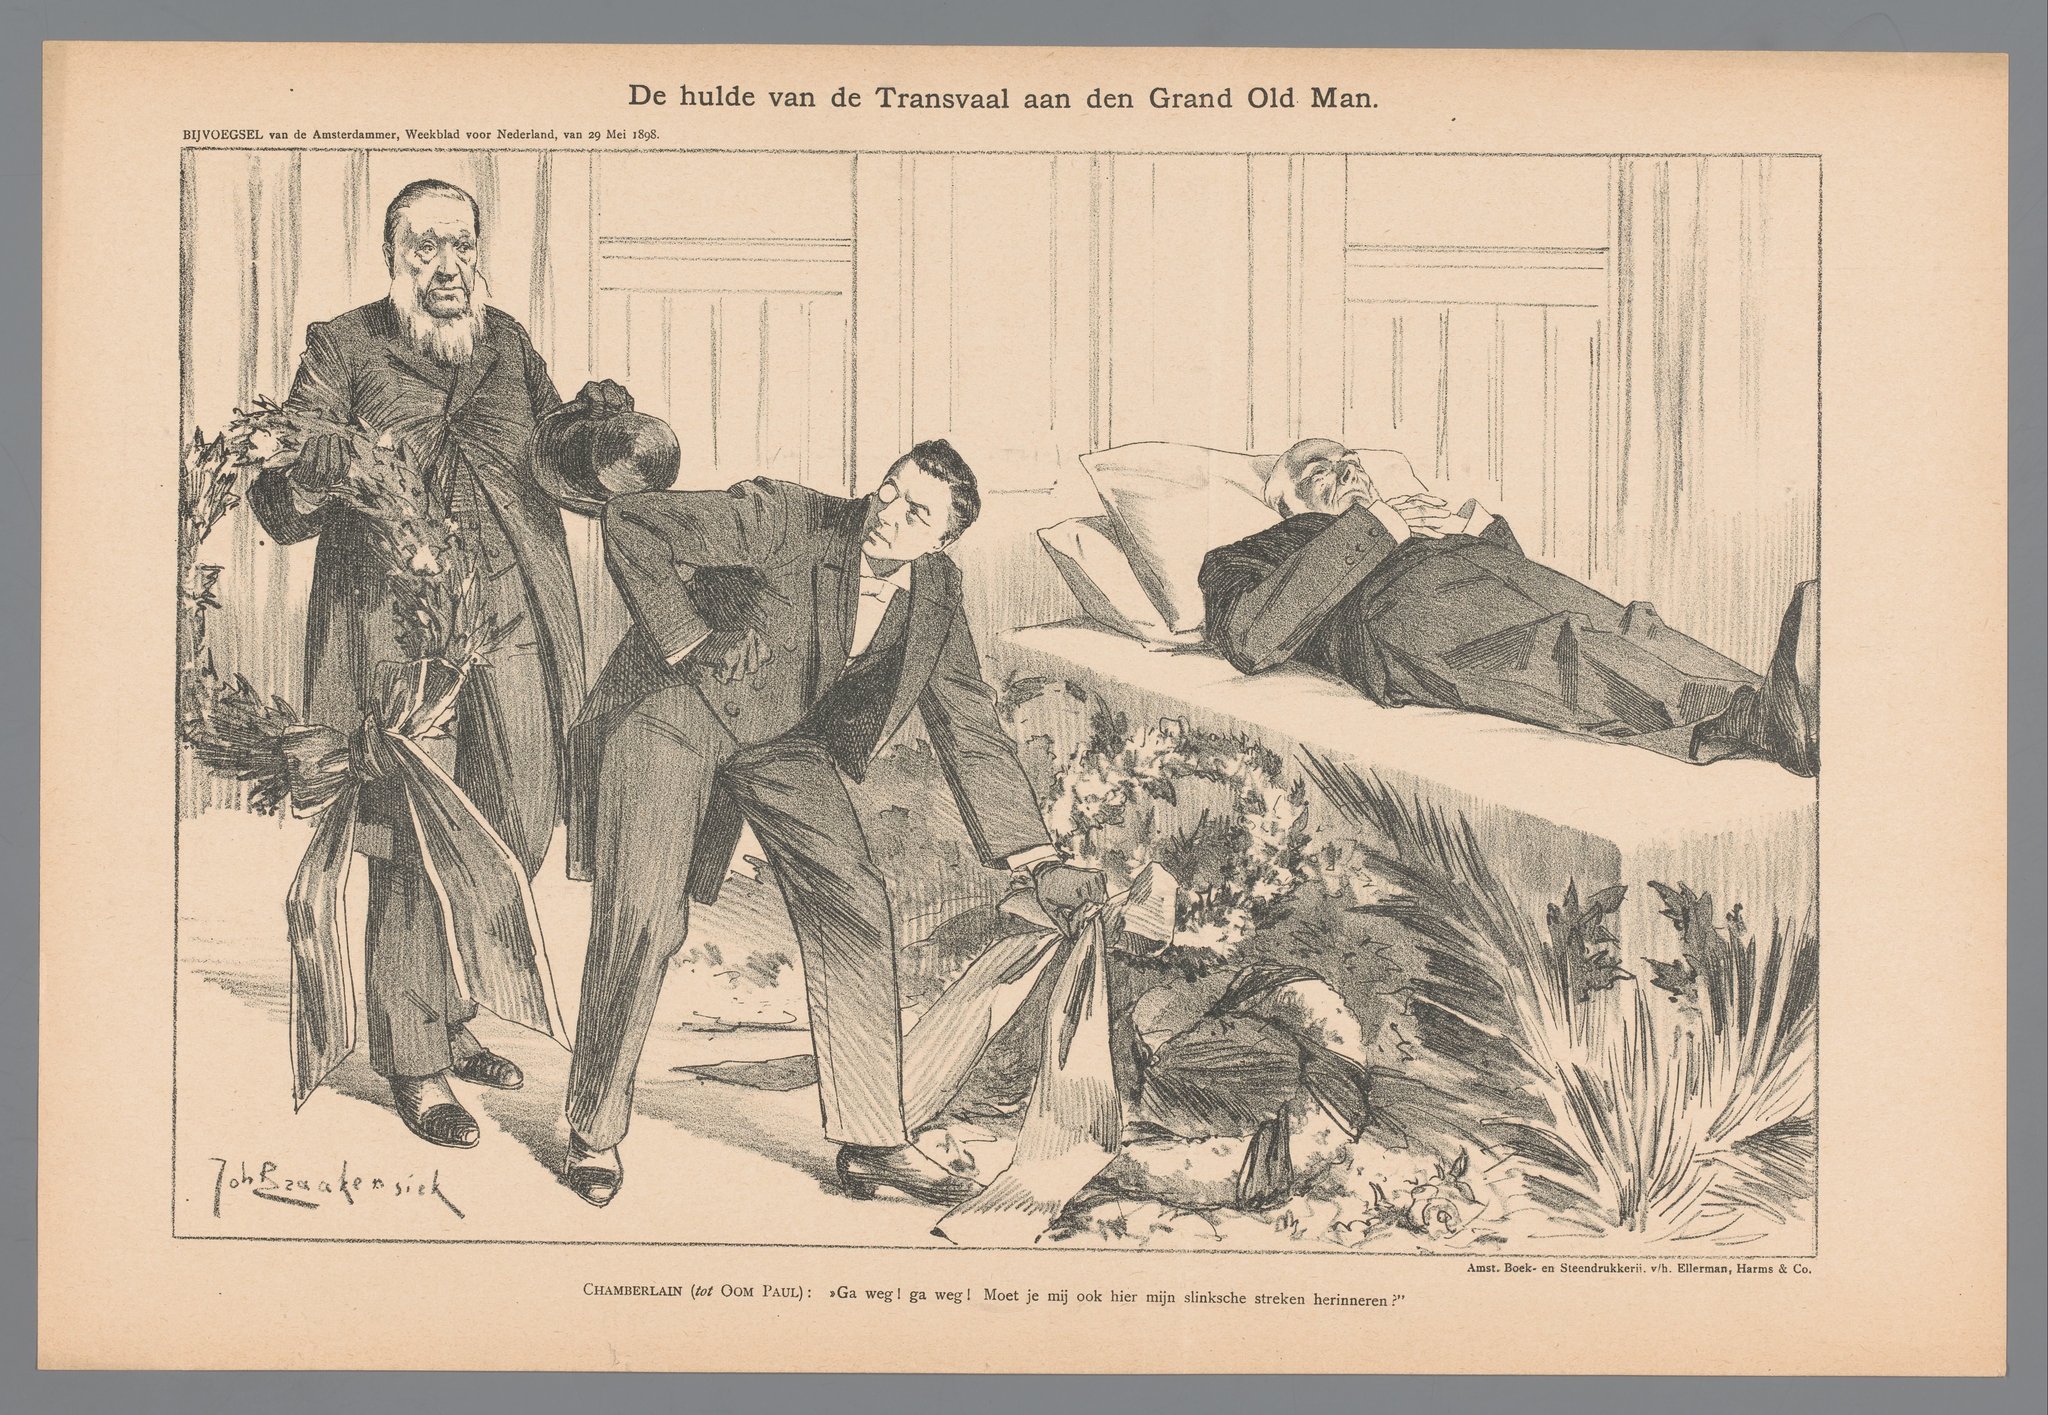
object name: cartoon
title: De Hulde van de Transvaal aan den Grand Old Man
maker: johan braakensiek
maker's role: draughtsman, print maker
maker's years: 1858-1940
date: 1898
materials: paper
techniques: lithograph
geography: amsterdam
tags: liverpool, politician, deathbed, historical persons, political caricatures and satires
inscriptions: date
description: Prent uit het bijvoegsel van: De Amsterdammer. Weekblad voor Nederland, 29 mei 1898.